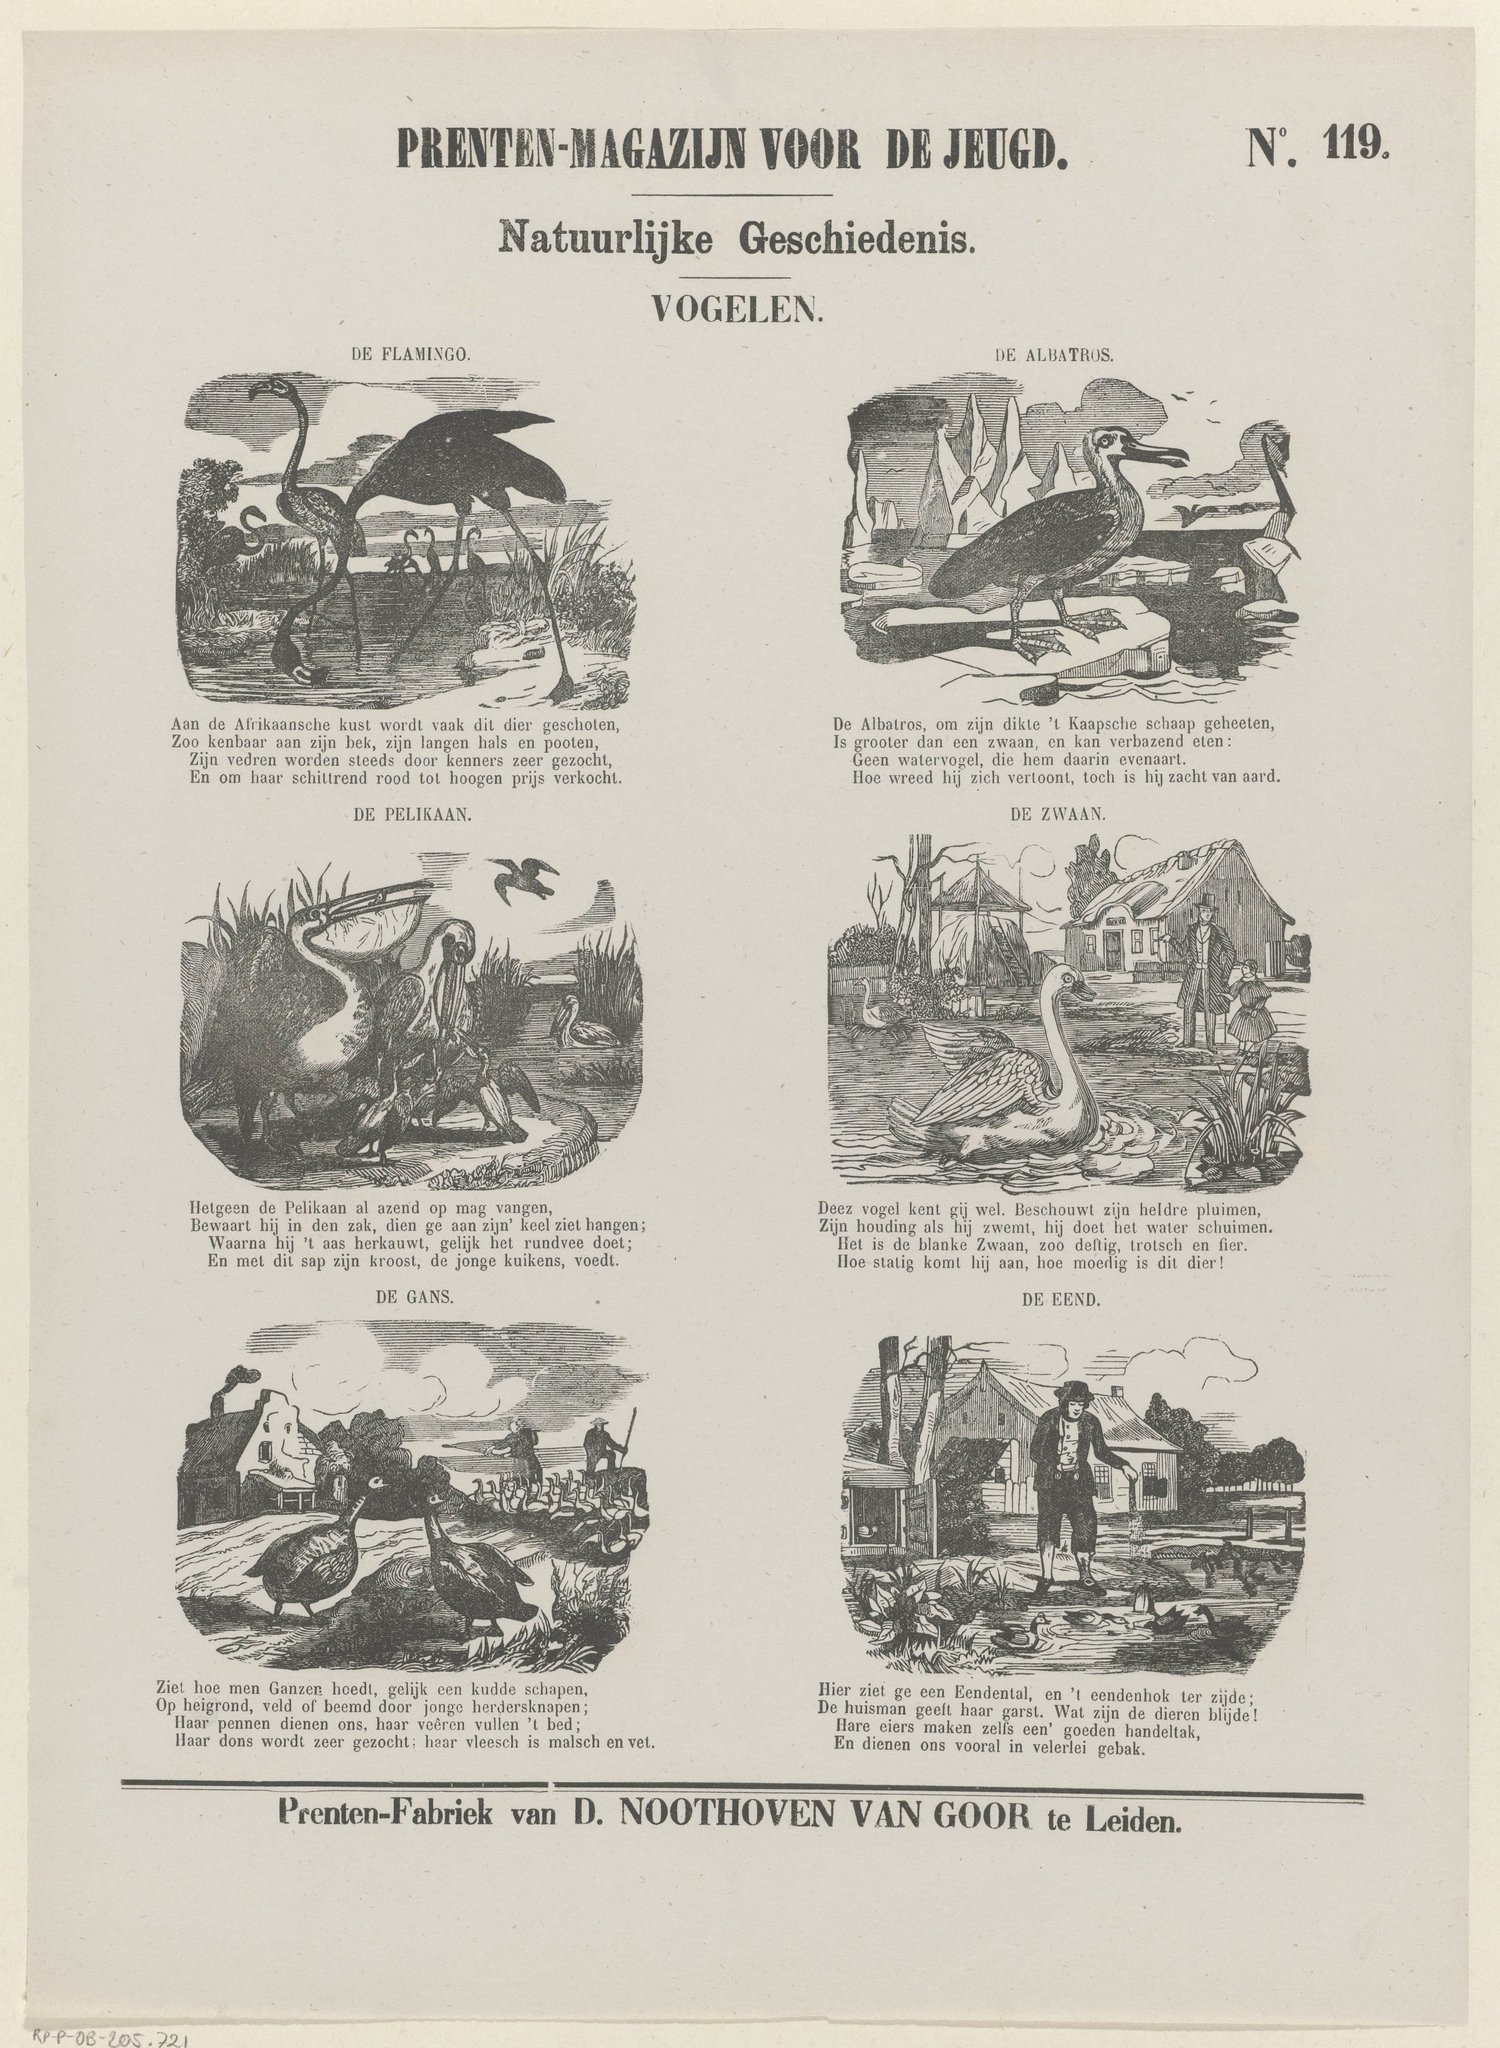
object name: print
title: Natuurlijke geschiedenis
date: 1850-1881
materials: paper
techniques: letterpress printing, engraving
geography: leiden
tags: water-birds: goose, water-birds: swan, birds, water-birds: duck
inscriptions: collector's mark: Lugt 2760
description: Blad met 6 voorstellingen van vogels, zoals een flamingo, een pelikaan en een gans. Boven elke afbeelding een titel, onder elke afbeelding een vierregelig vers. Genummerd rechtsboven: No. 119.